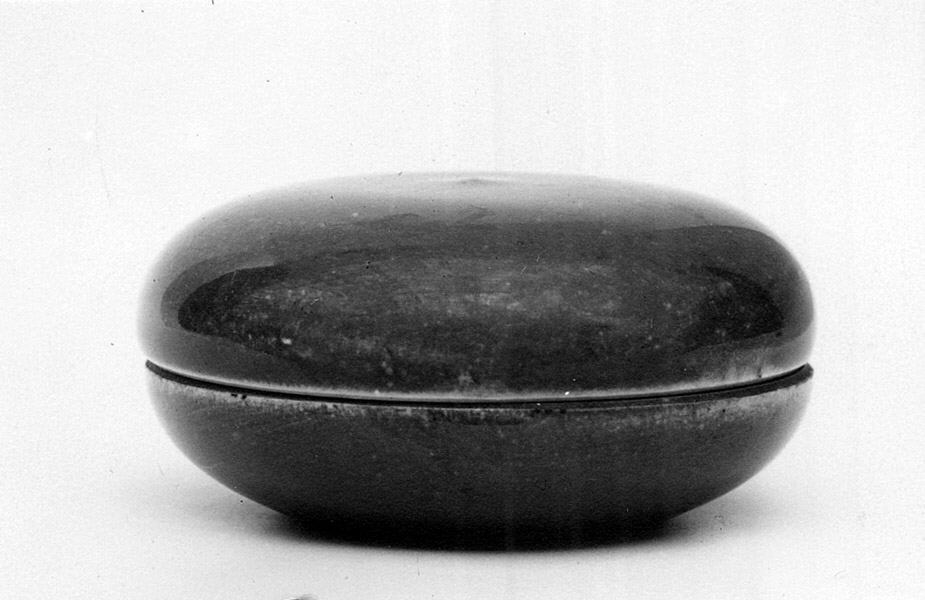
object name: box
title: Covered Seal-Ink Box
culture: chinese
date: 1601-1800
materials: glaze, porcelain